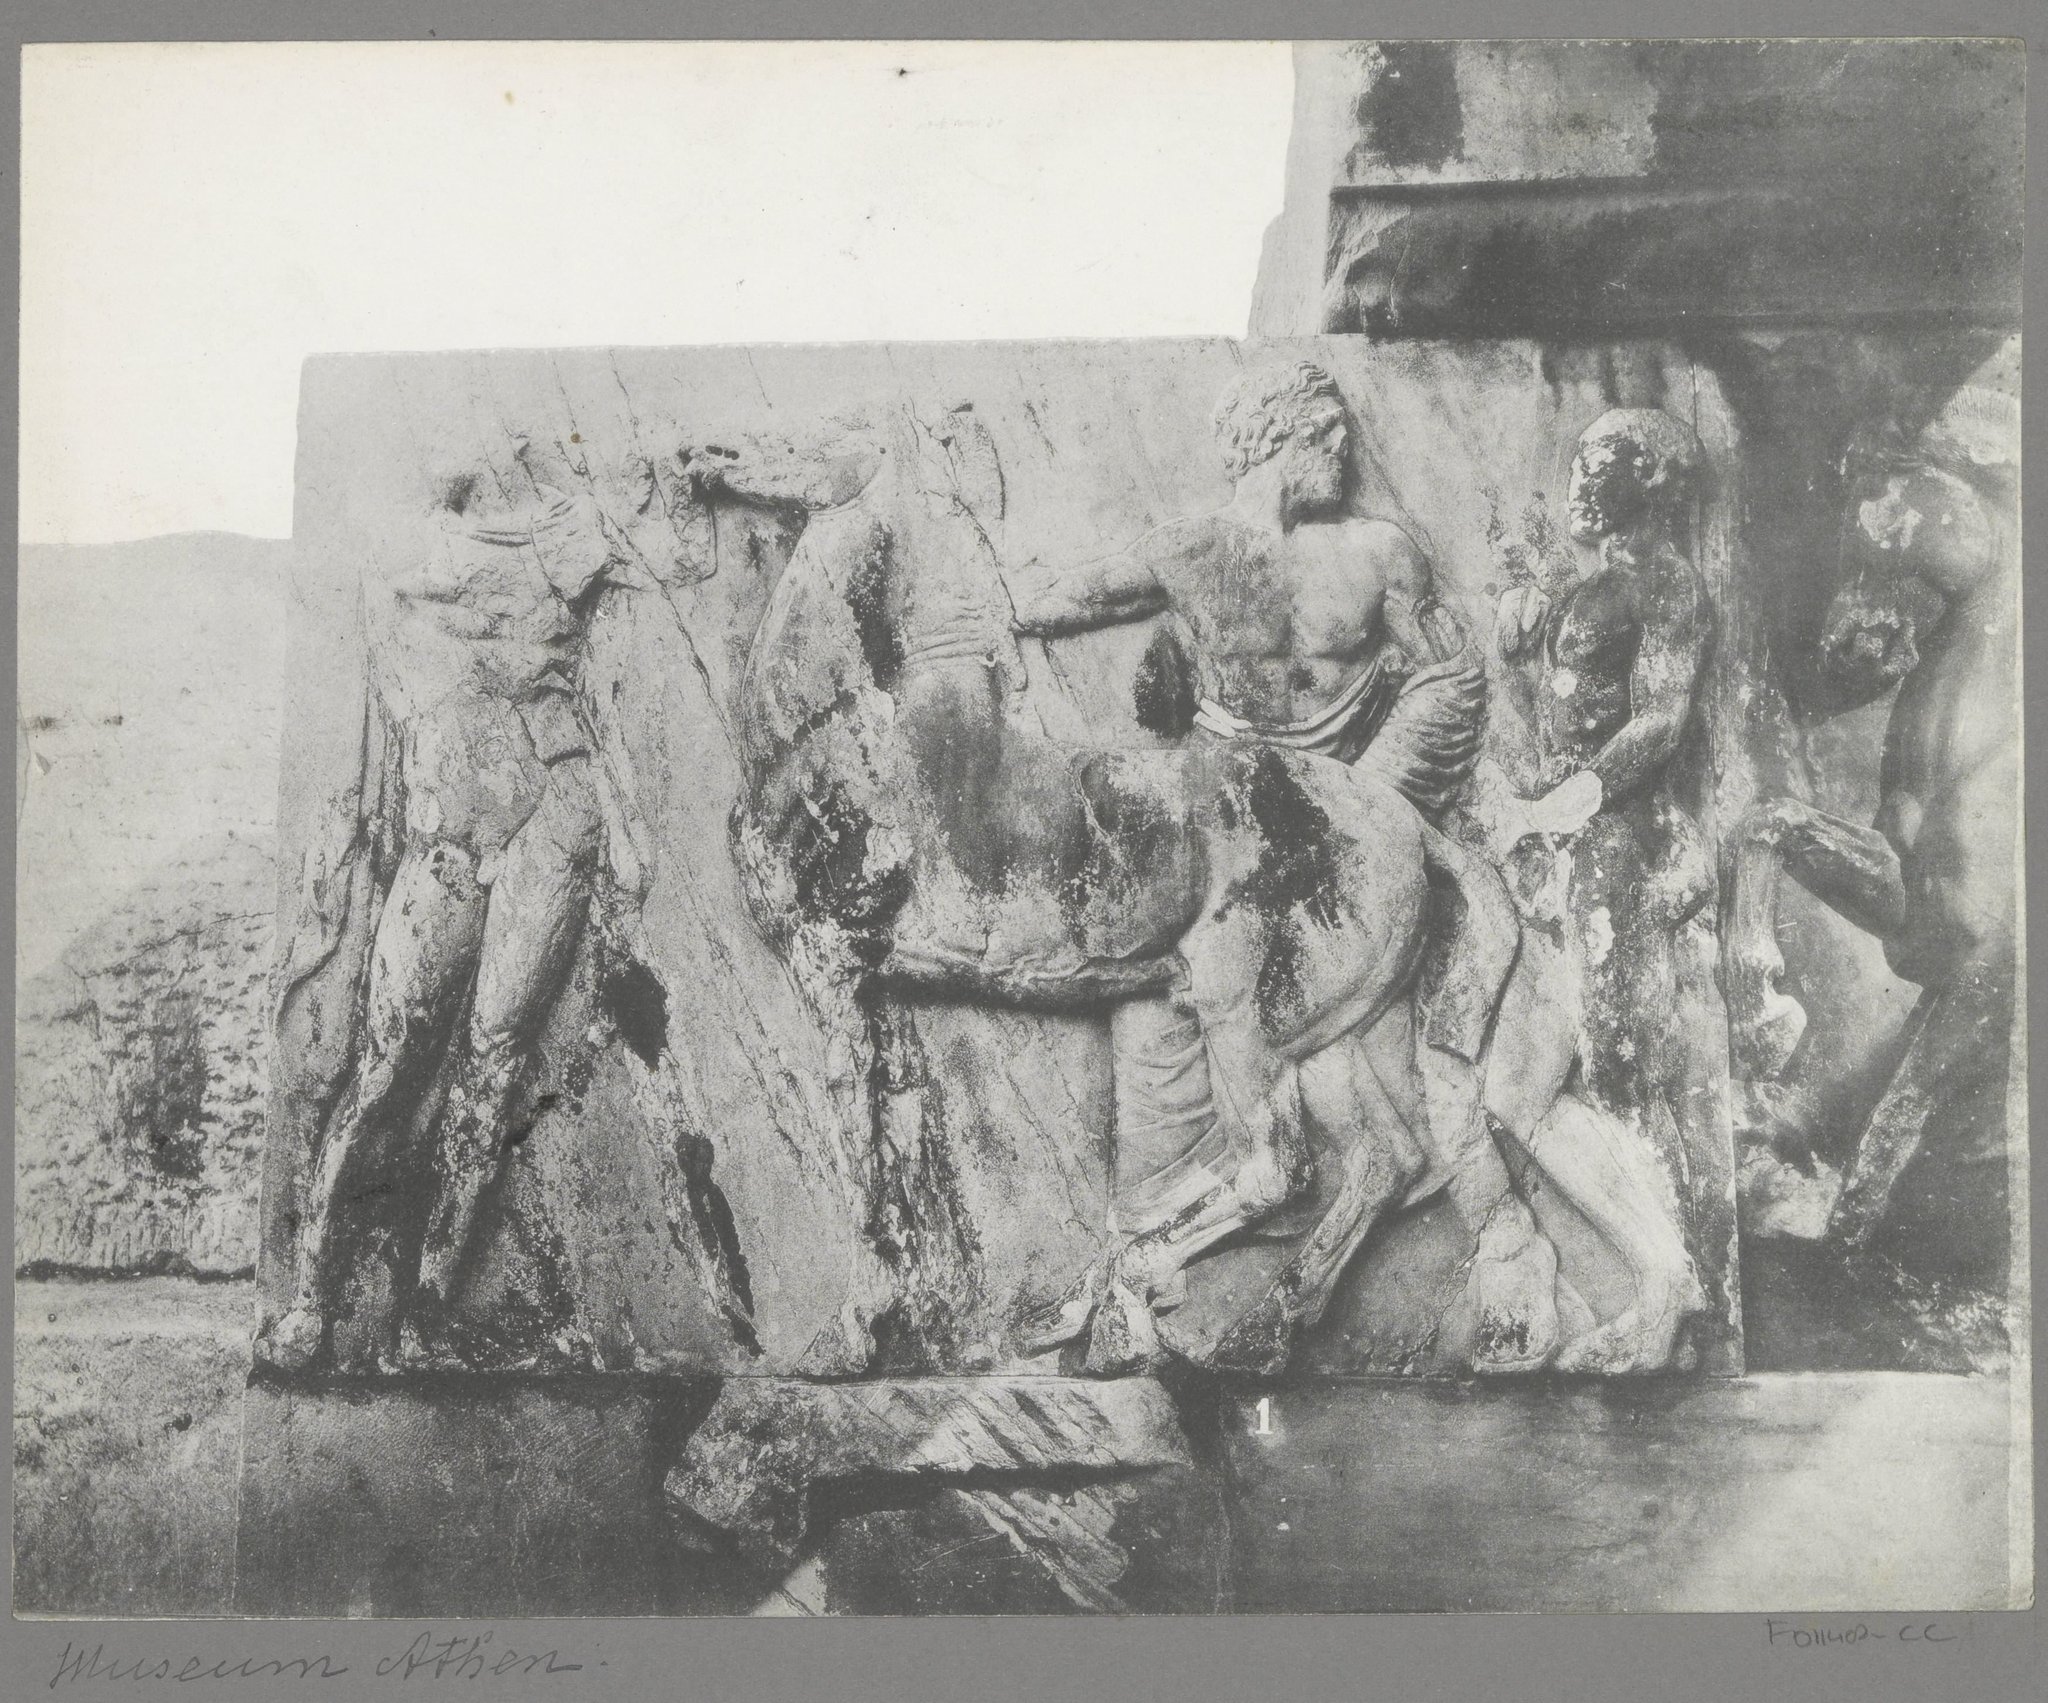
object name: photograph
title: Reliëf van mannen met paard in een museum in Athene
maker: Anonymous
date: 1895-1905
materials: paper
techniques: photograph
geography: athens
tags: sculpture (+ relief ~ sculpture)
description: Onderdeel van Reisalbum met foto's van bezienswaardigheden in Griekenland en Egypte.